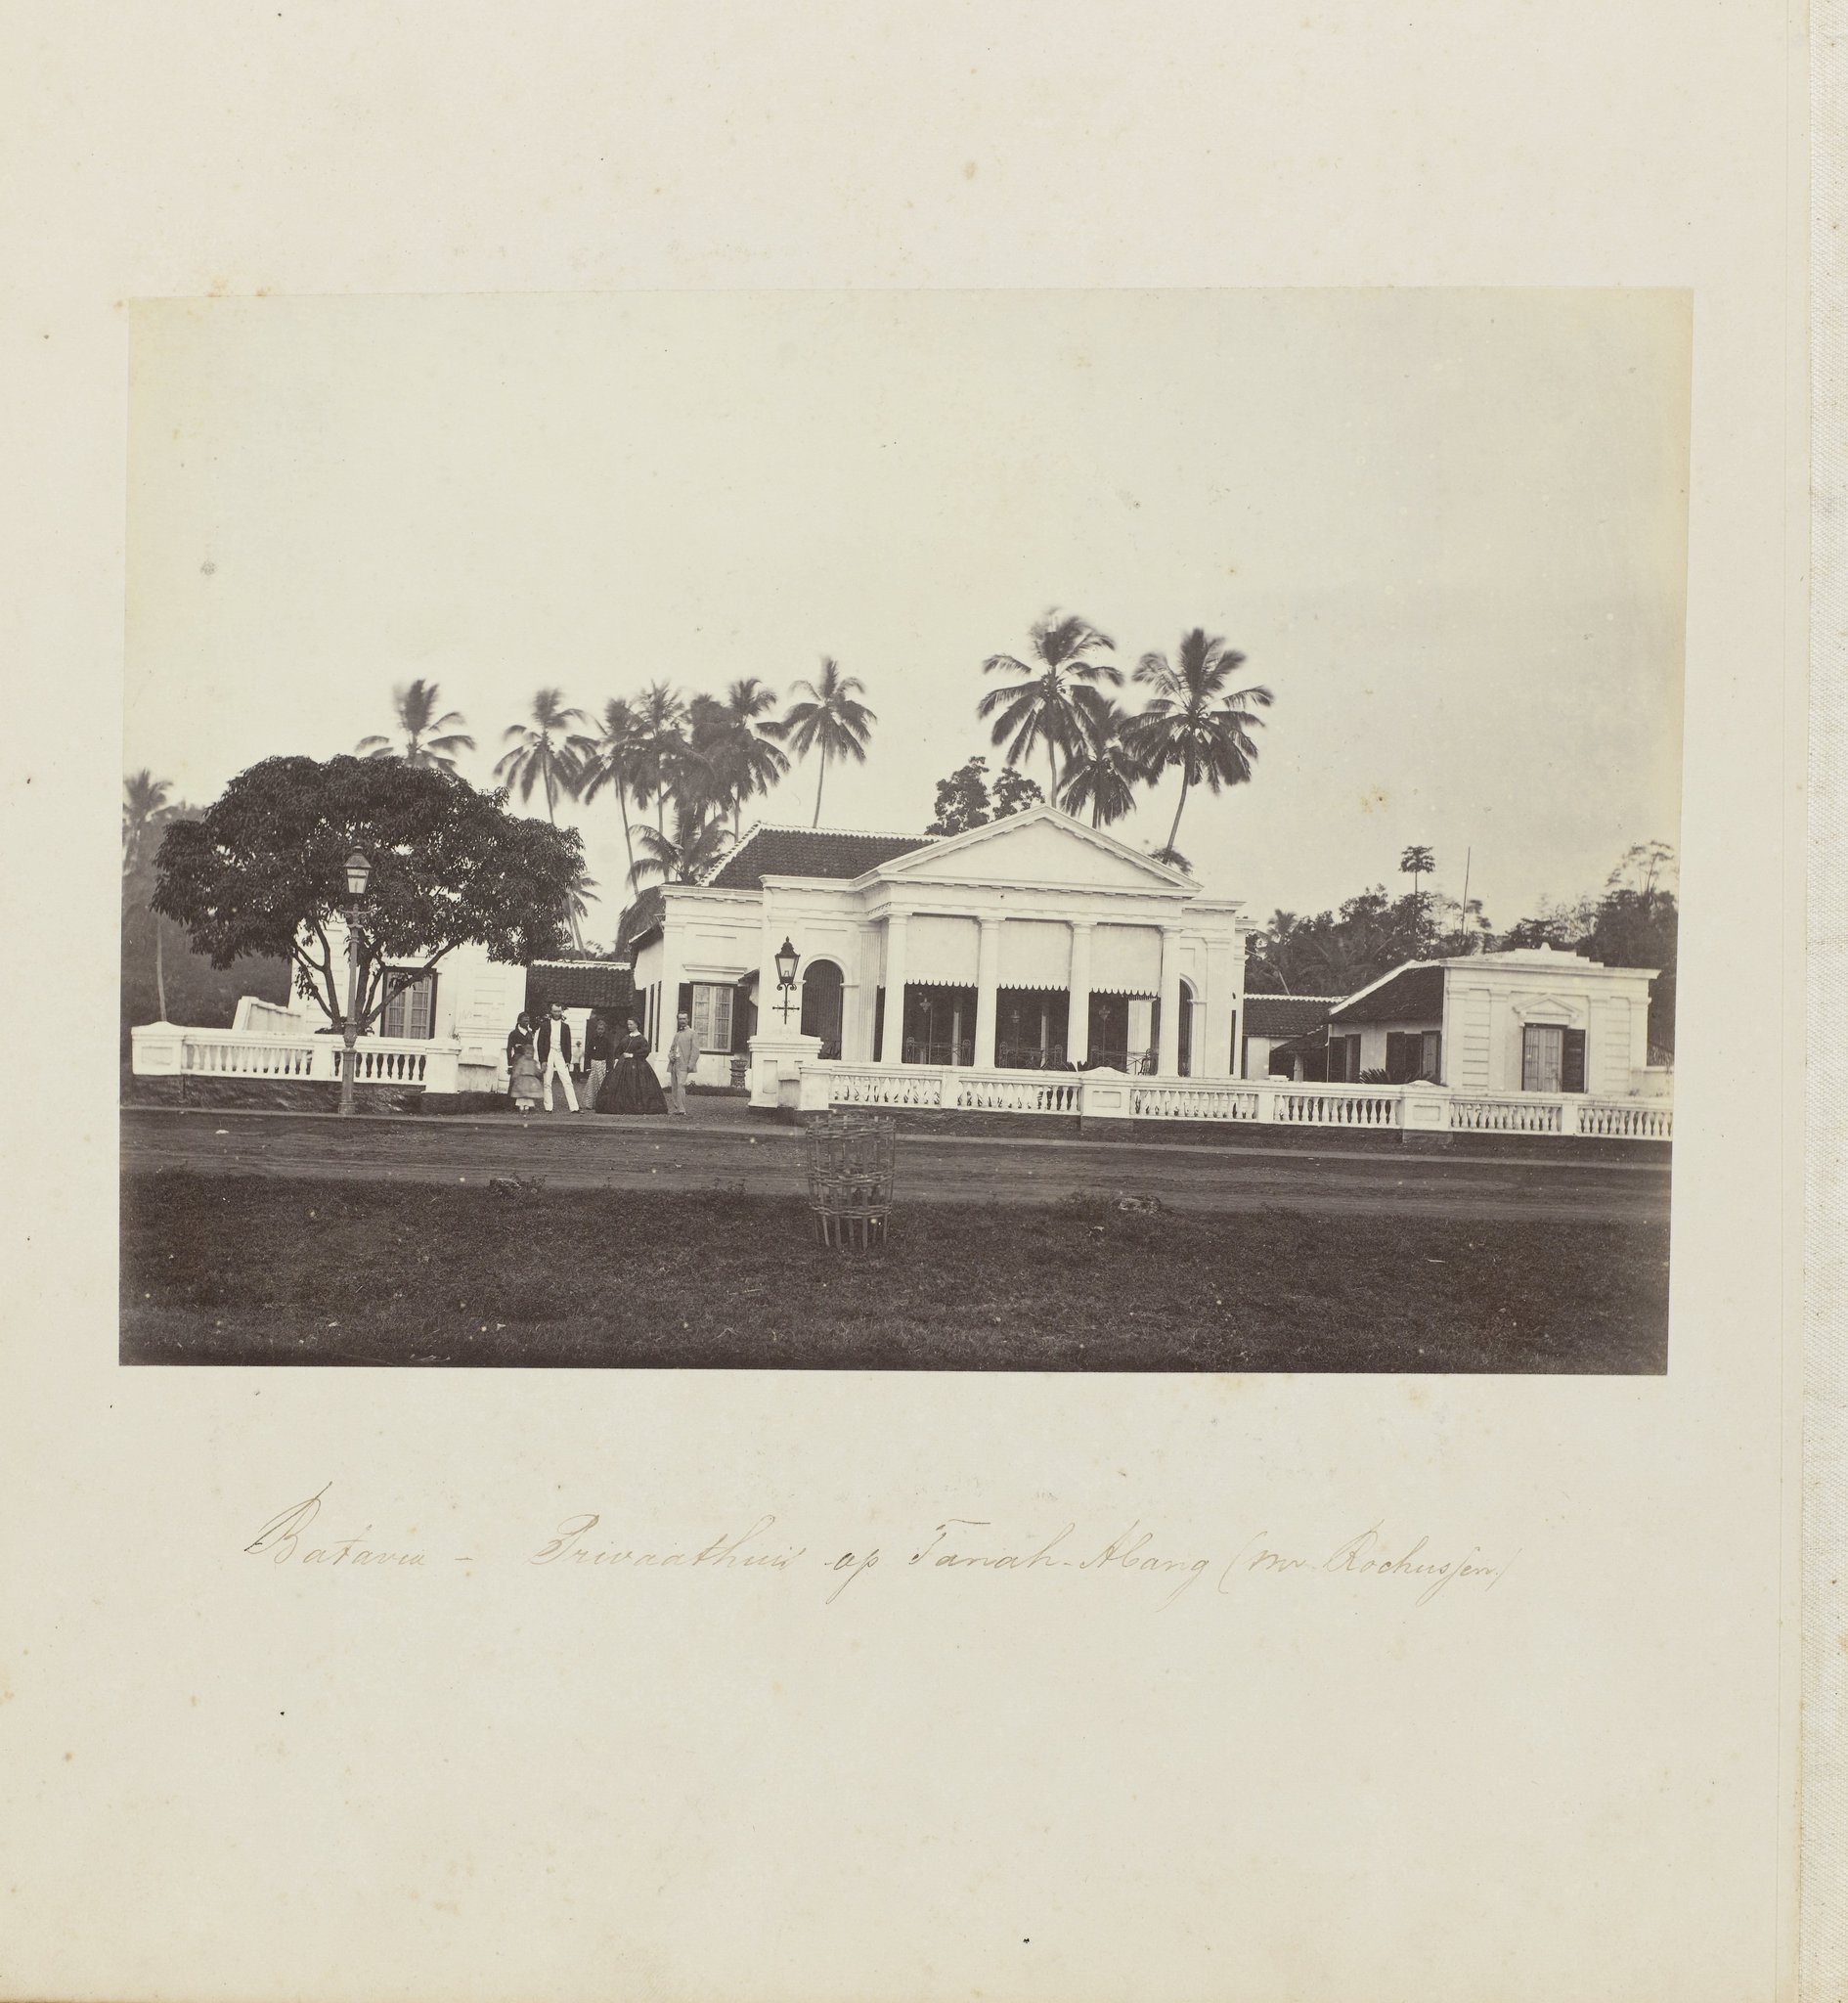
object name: photograph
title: Batavia - Privaathuis op Tanah-Abang (mr. Rochussen)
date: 1863-1866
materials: photographic support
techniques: albumen print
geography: batavia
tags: detached house in city, batavia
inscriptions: inscription: ‘Batavia - Privaathuis op Tanah-Abang (mr. Rochussen)’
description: Het woonhuis van mr. Henri Rochussen in de Tanah Abang in Batavia. Rochussen poseert met vrouw en kind en personeel bij de ingang. Onderdeel van het rode fotoalbum met foto's van Java, uit het bezit van apotheker Specht-Grijp, die in 1865 vanuit Batavia naar Nederland terugkeerde.